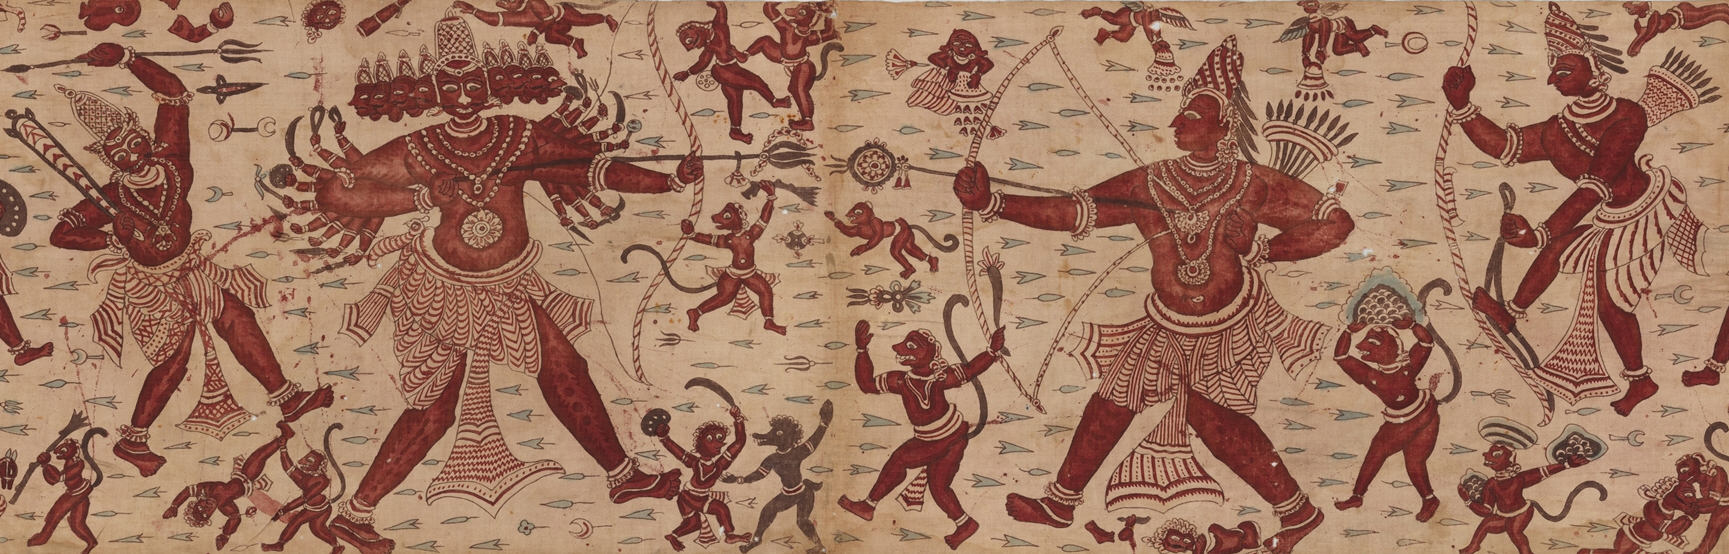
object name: textile hanging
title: The Combat of Rama and Ravana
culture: indian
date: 1767-1800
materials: cotton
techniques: dyeing, painting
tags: battles,bow and arrow,monkeys,demons,hinduism